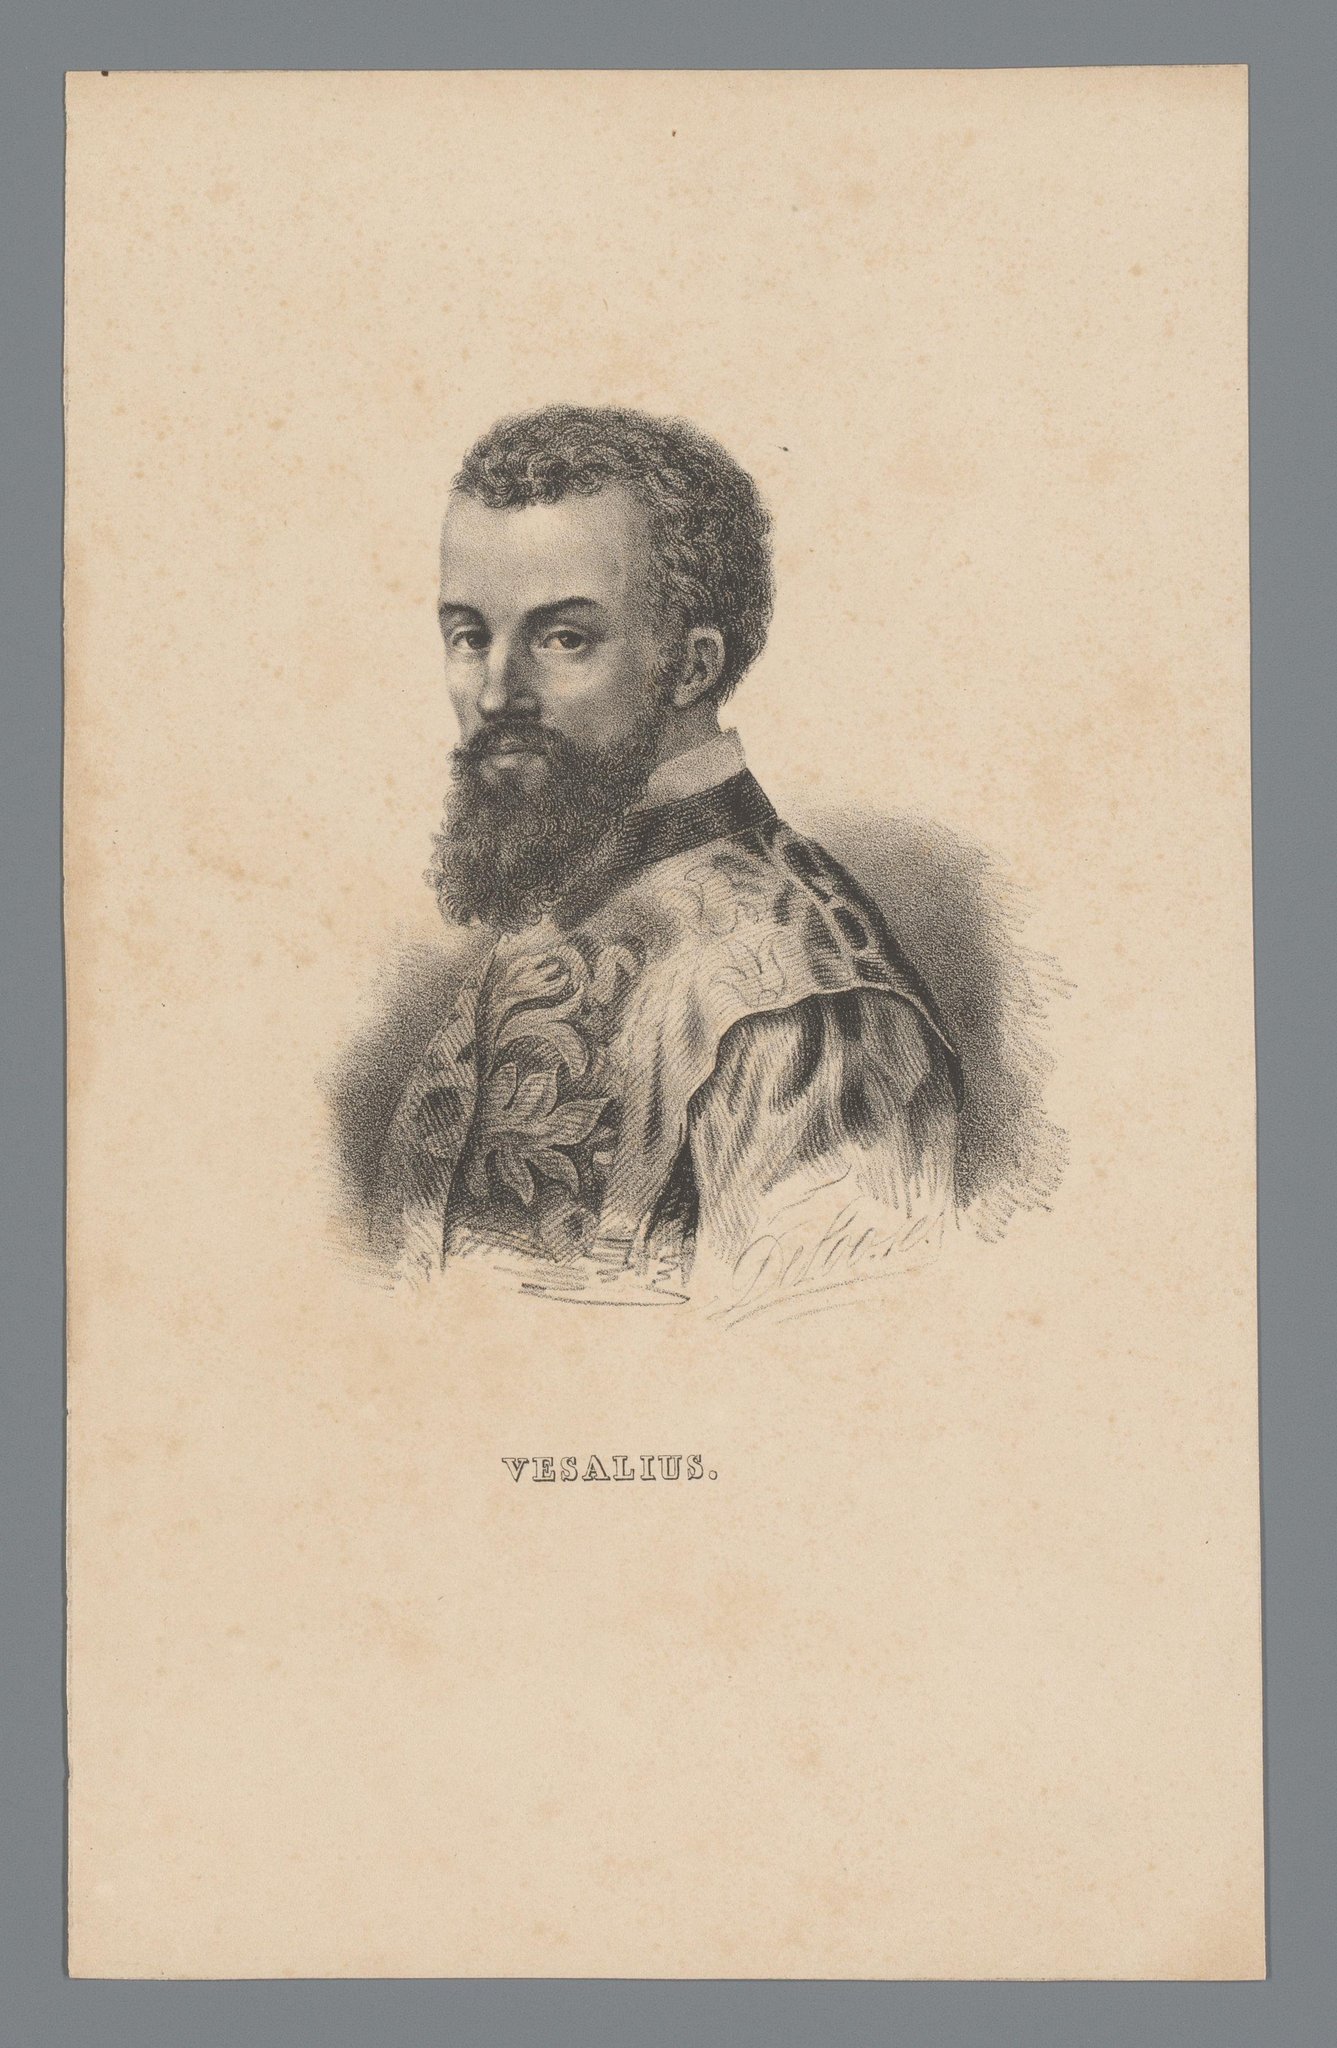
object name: print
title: Portret van Andreas Vesalius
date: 1800-1899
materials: paper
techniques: lithograph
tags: brussels, adult man, historical persons, beard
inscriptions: collector's mark: Lugt 2228